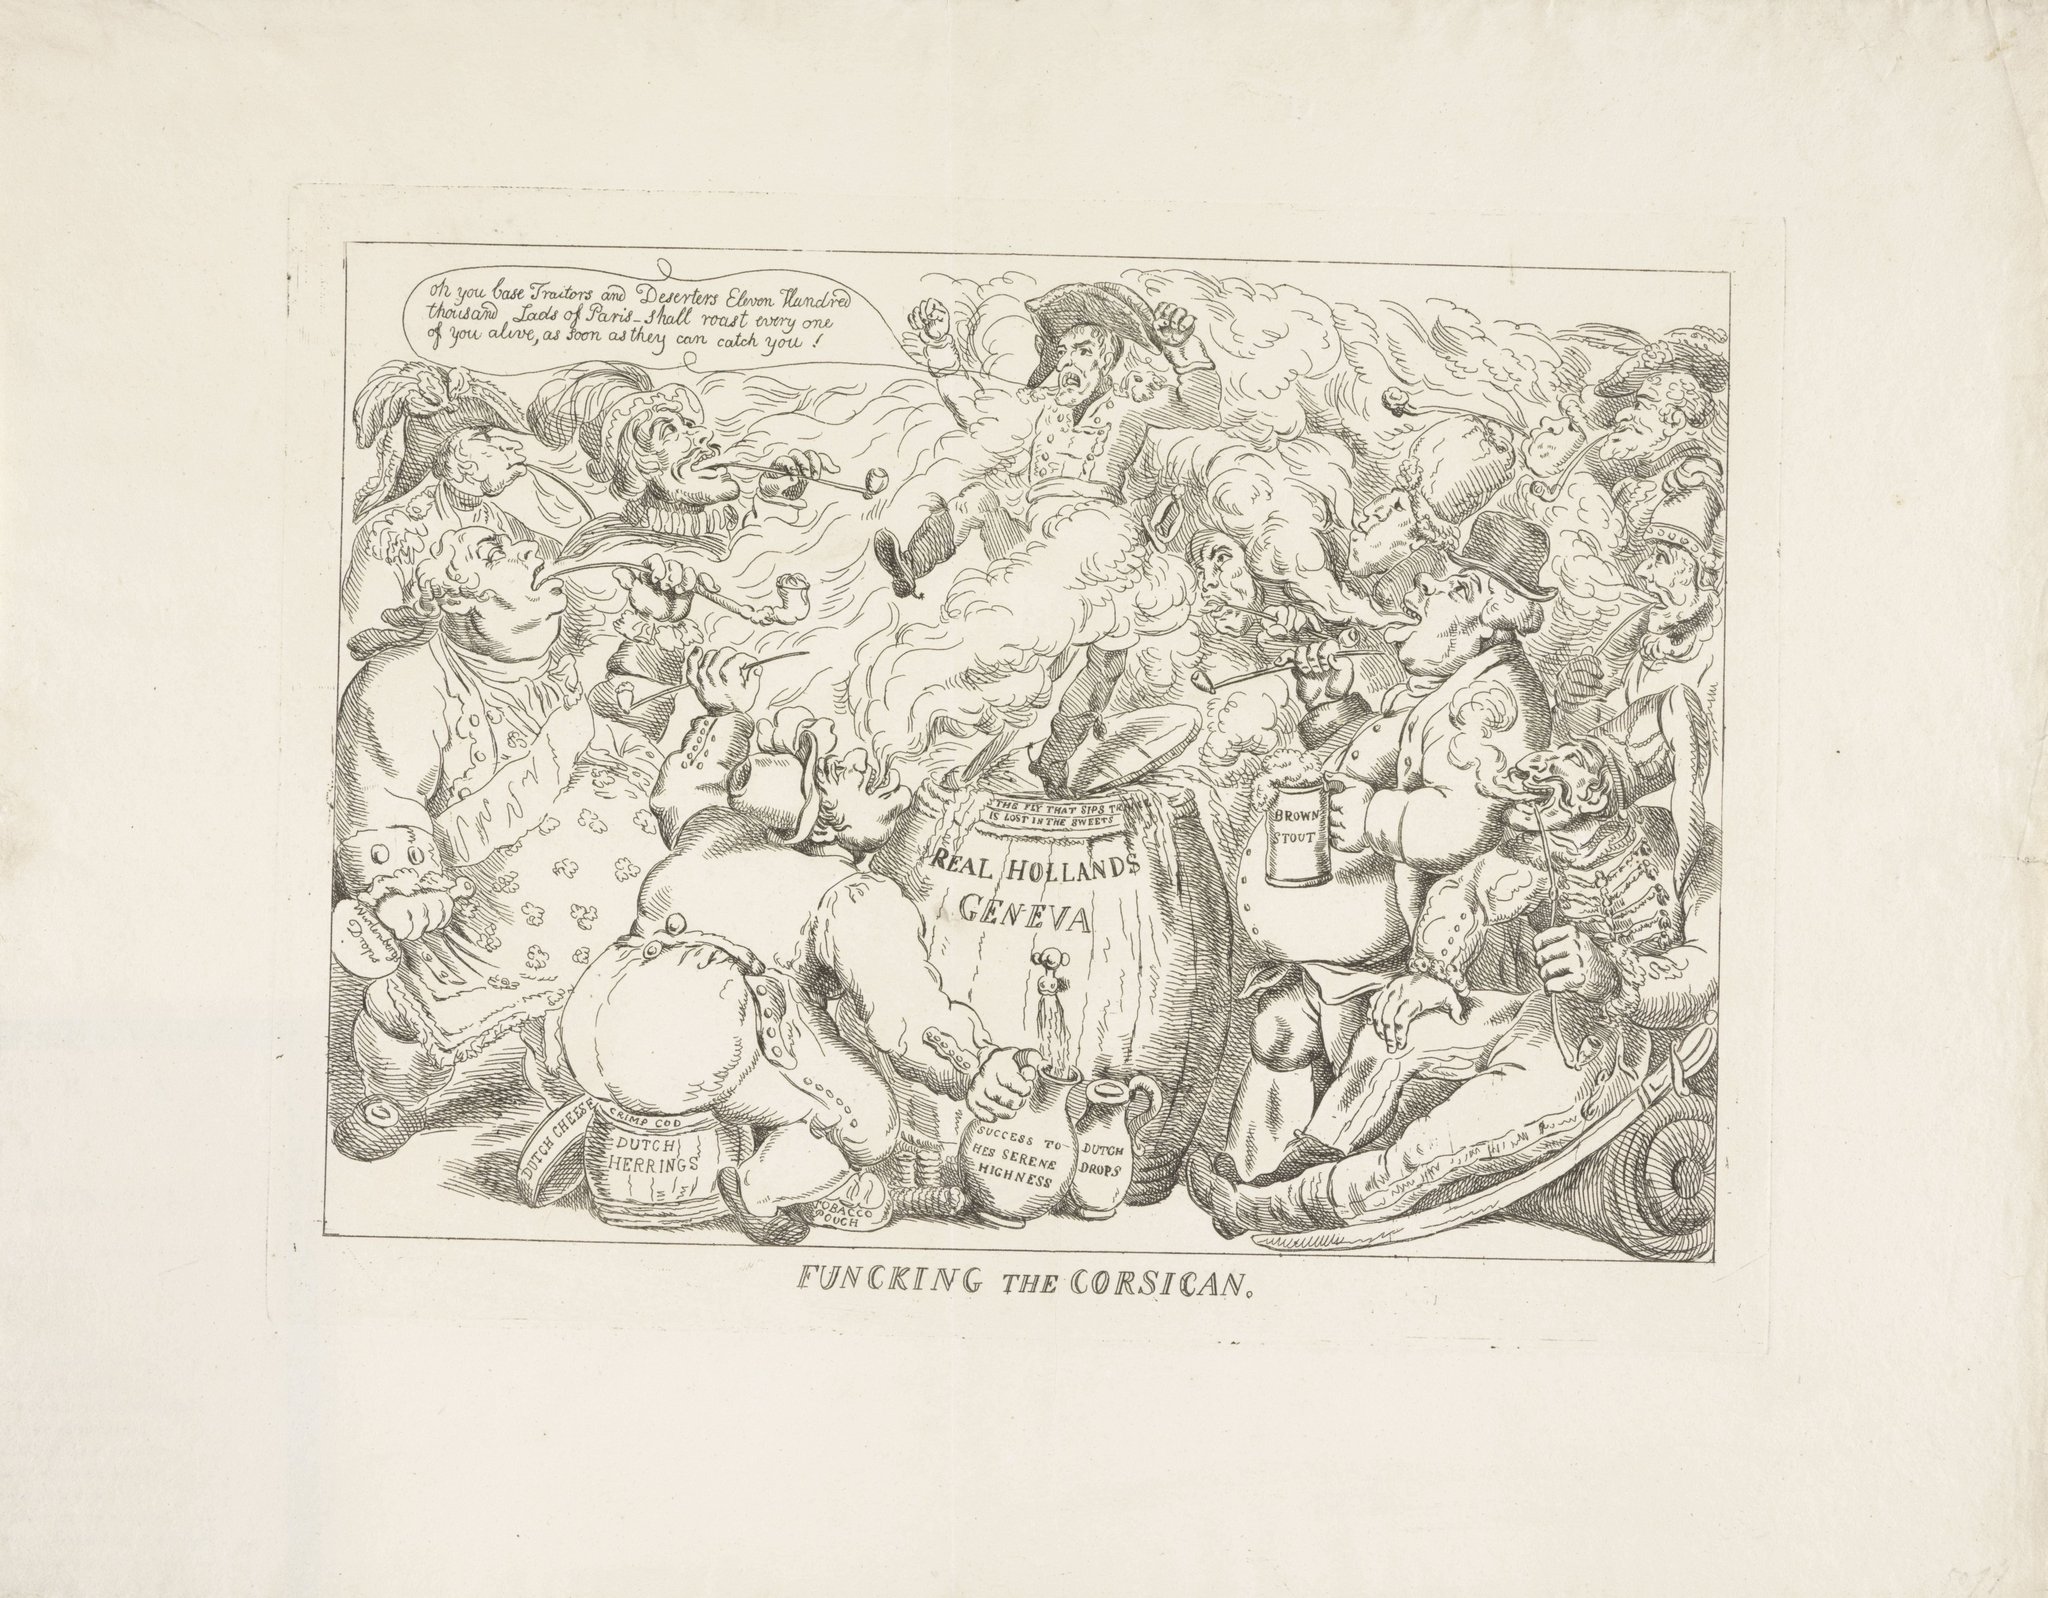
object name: cartoon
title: Beroking van de Corsicaan, 1813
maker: Anonymous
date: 1813-1815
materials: paper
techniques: etching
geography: england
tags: napoleon i (emperor of the french), smoke, personifications of countries, nations, states, districts, etc., pipe ~ tobacco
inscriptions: collector's mark: Lugt 2228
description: Spotprent op Napoleon na zijn verlies in de slag bij Leipzig, 1813. Een kleine figuur van Napoleon staat boos te stampvoeten bovenop een grote houten vat met Hollandse jenever waardoor de deksel los raakt. Vertegenwoordigers van verschillende Europese landen roken allen pijp en blazen tabaksrook naar de keizer. Vooraan een dikke Hollander gezeten op een tonnetje haring en een kaas, Rechts de Engelse John Bull, een Pruisische huzaar en anderen. Links de koning van Württemberg, een Oostenrijker en een Spanjaard. Bij de prent behoort een afzonderlijke verklaring.